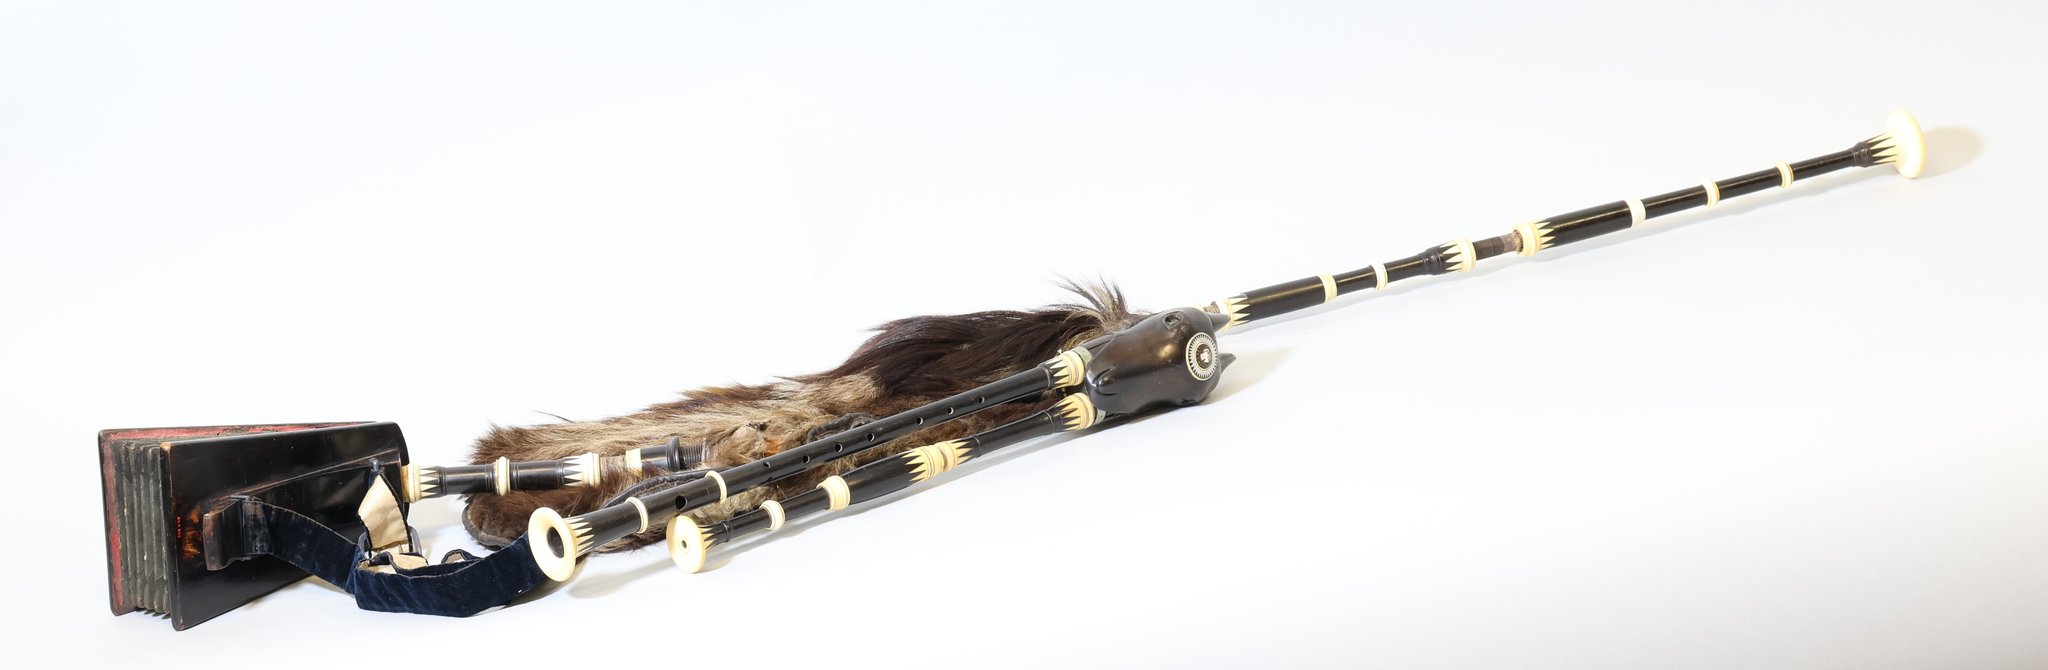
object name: cornemuse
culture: french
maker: joseph bechonnet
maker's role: maker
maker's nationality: french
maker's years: 1820-1900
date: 1801-1900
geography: france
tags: animals